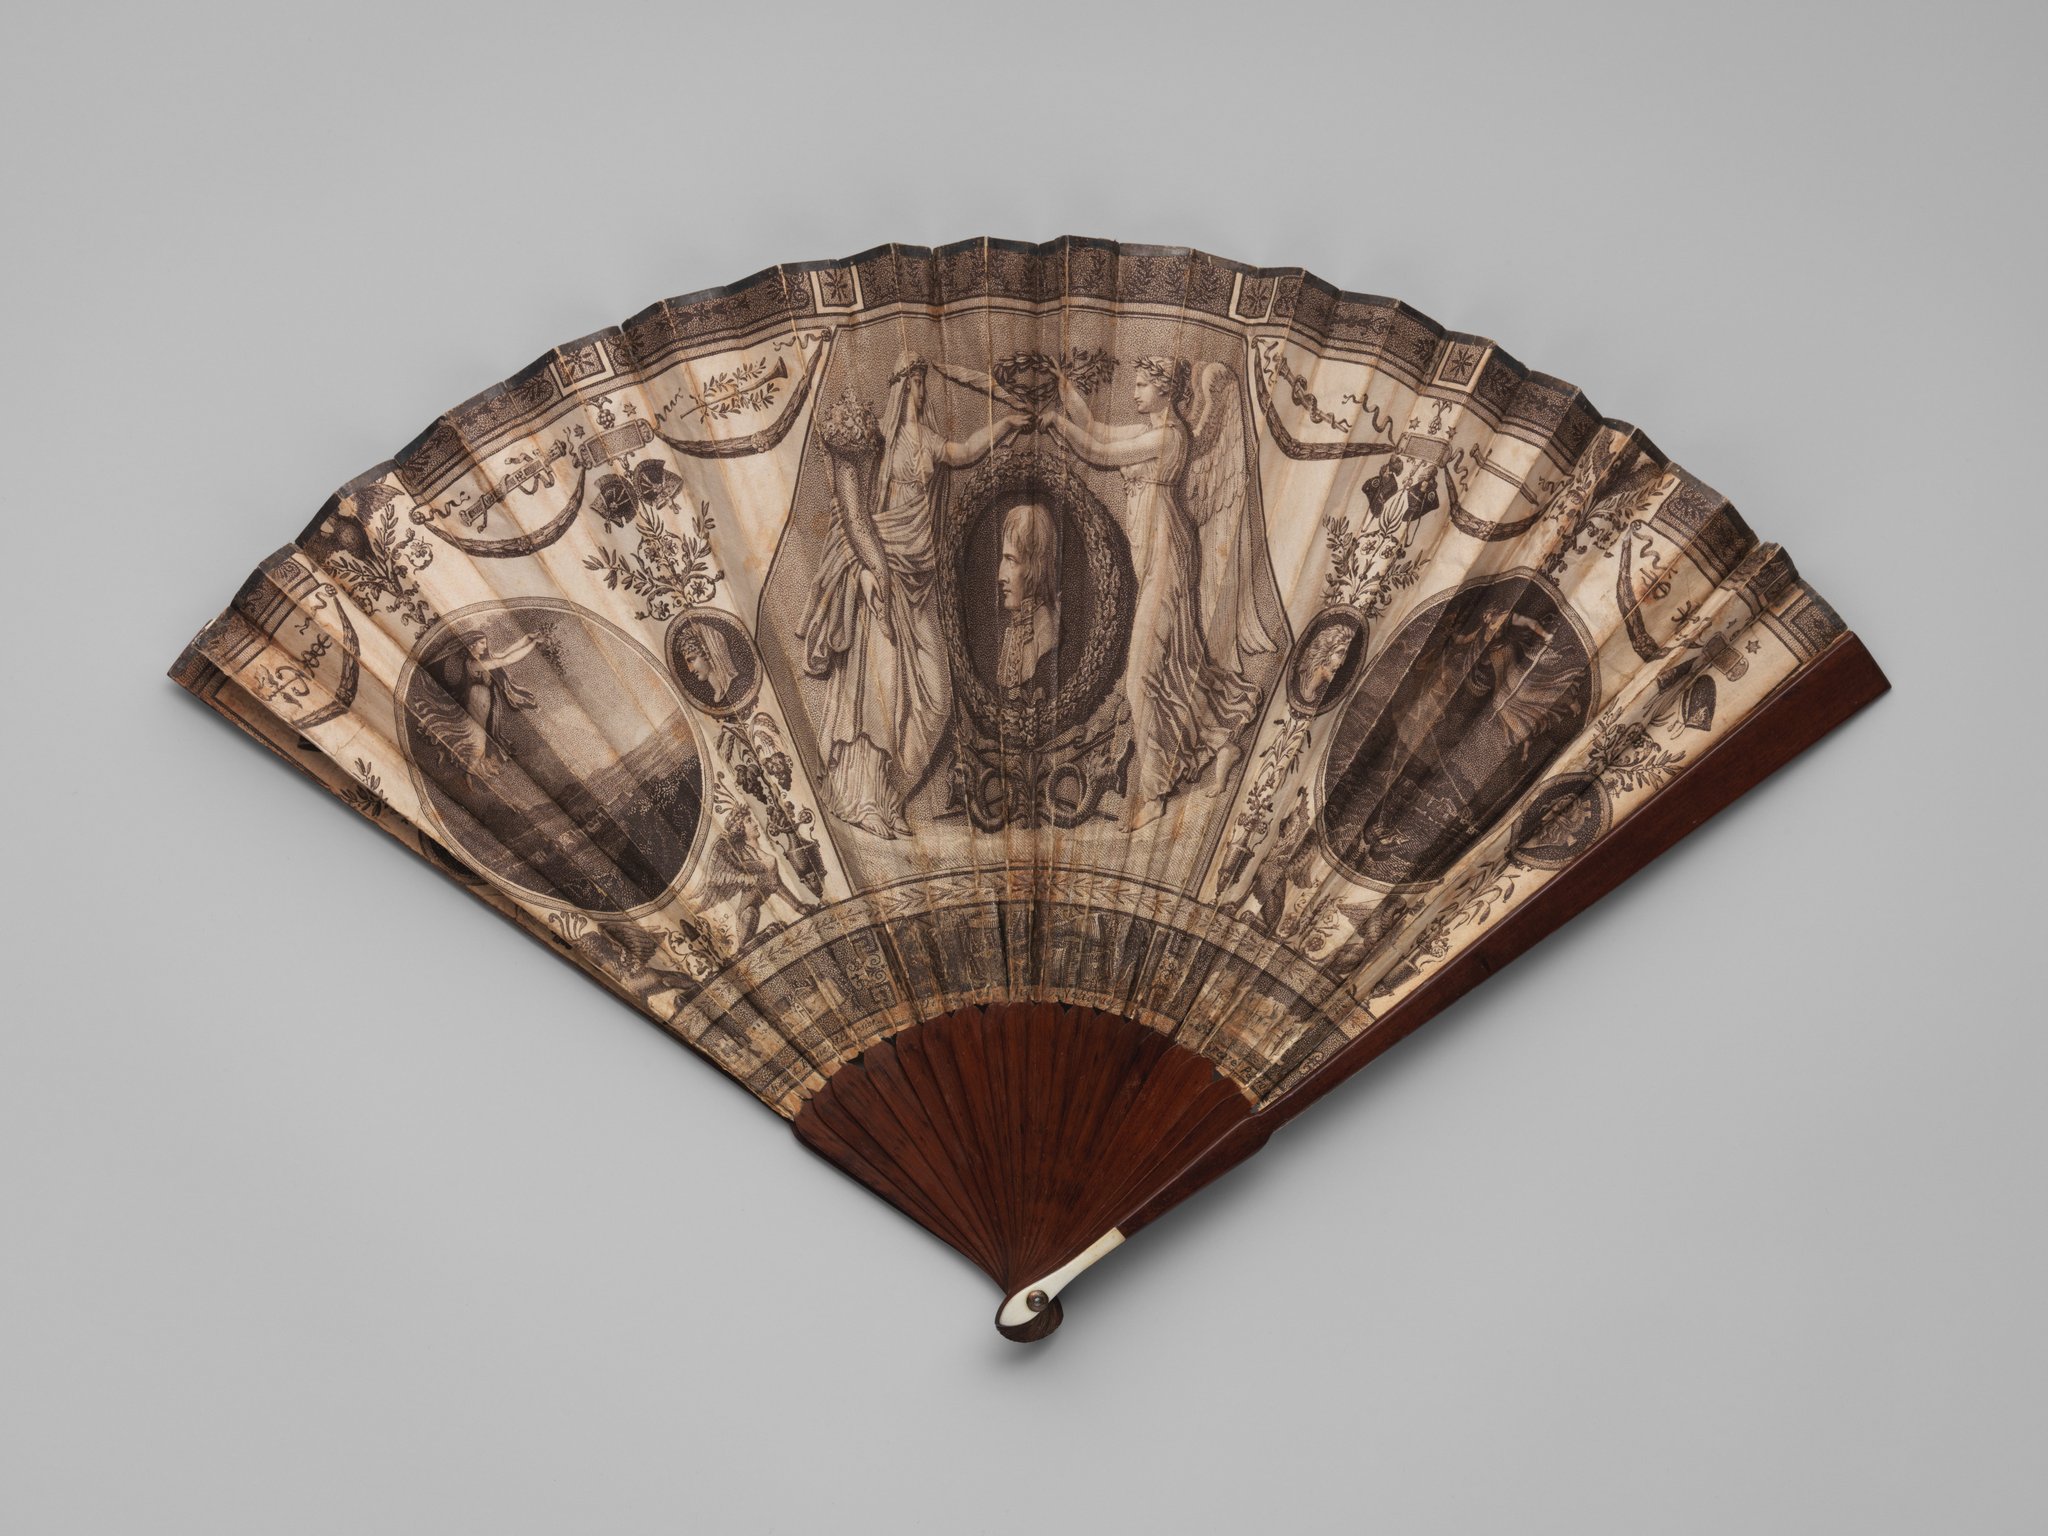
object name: fan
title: Fan with Napoleon flanked by Peace and Victory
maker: charles percier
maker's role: designer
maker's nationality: french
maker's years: 1764-1838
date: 1797-1799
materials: bone, paper, wood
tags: napoleon i